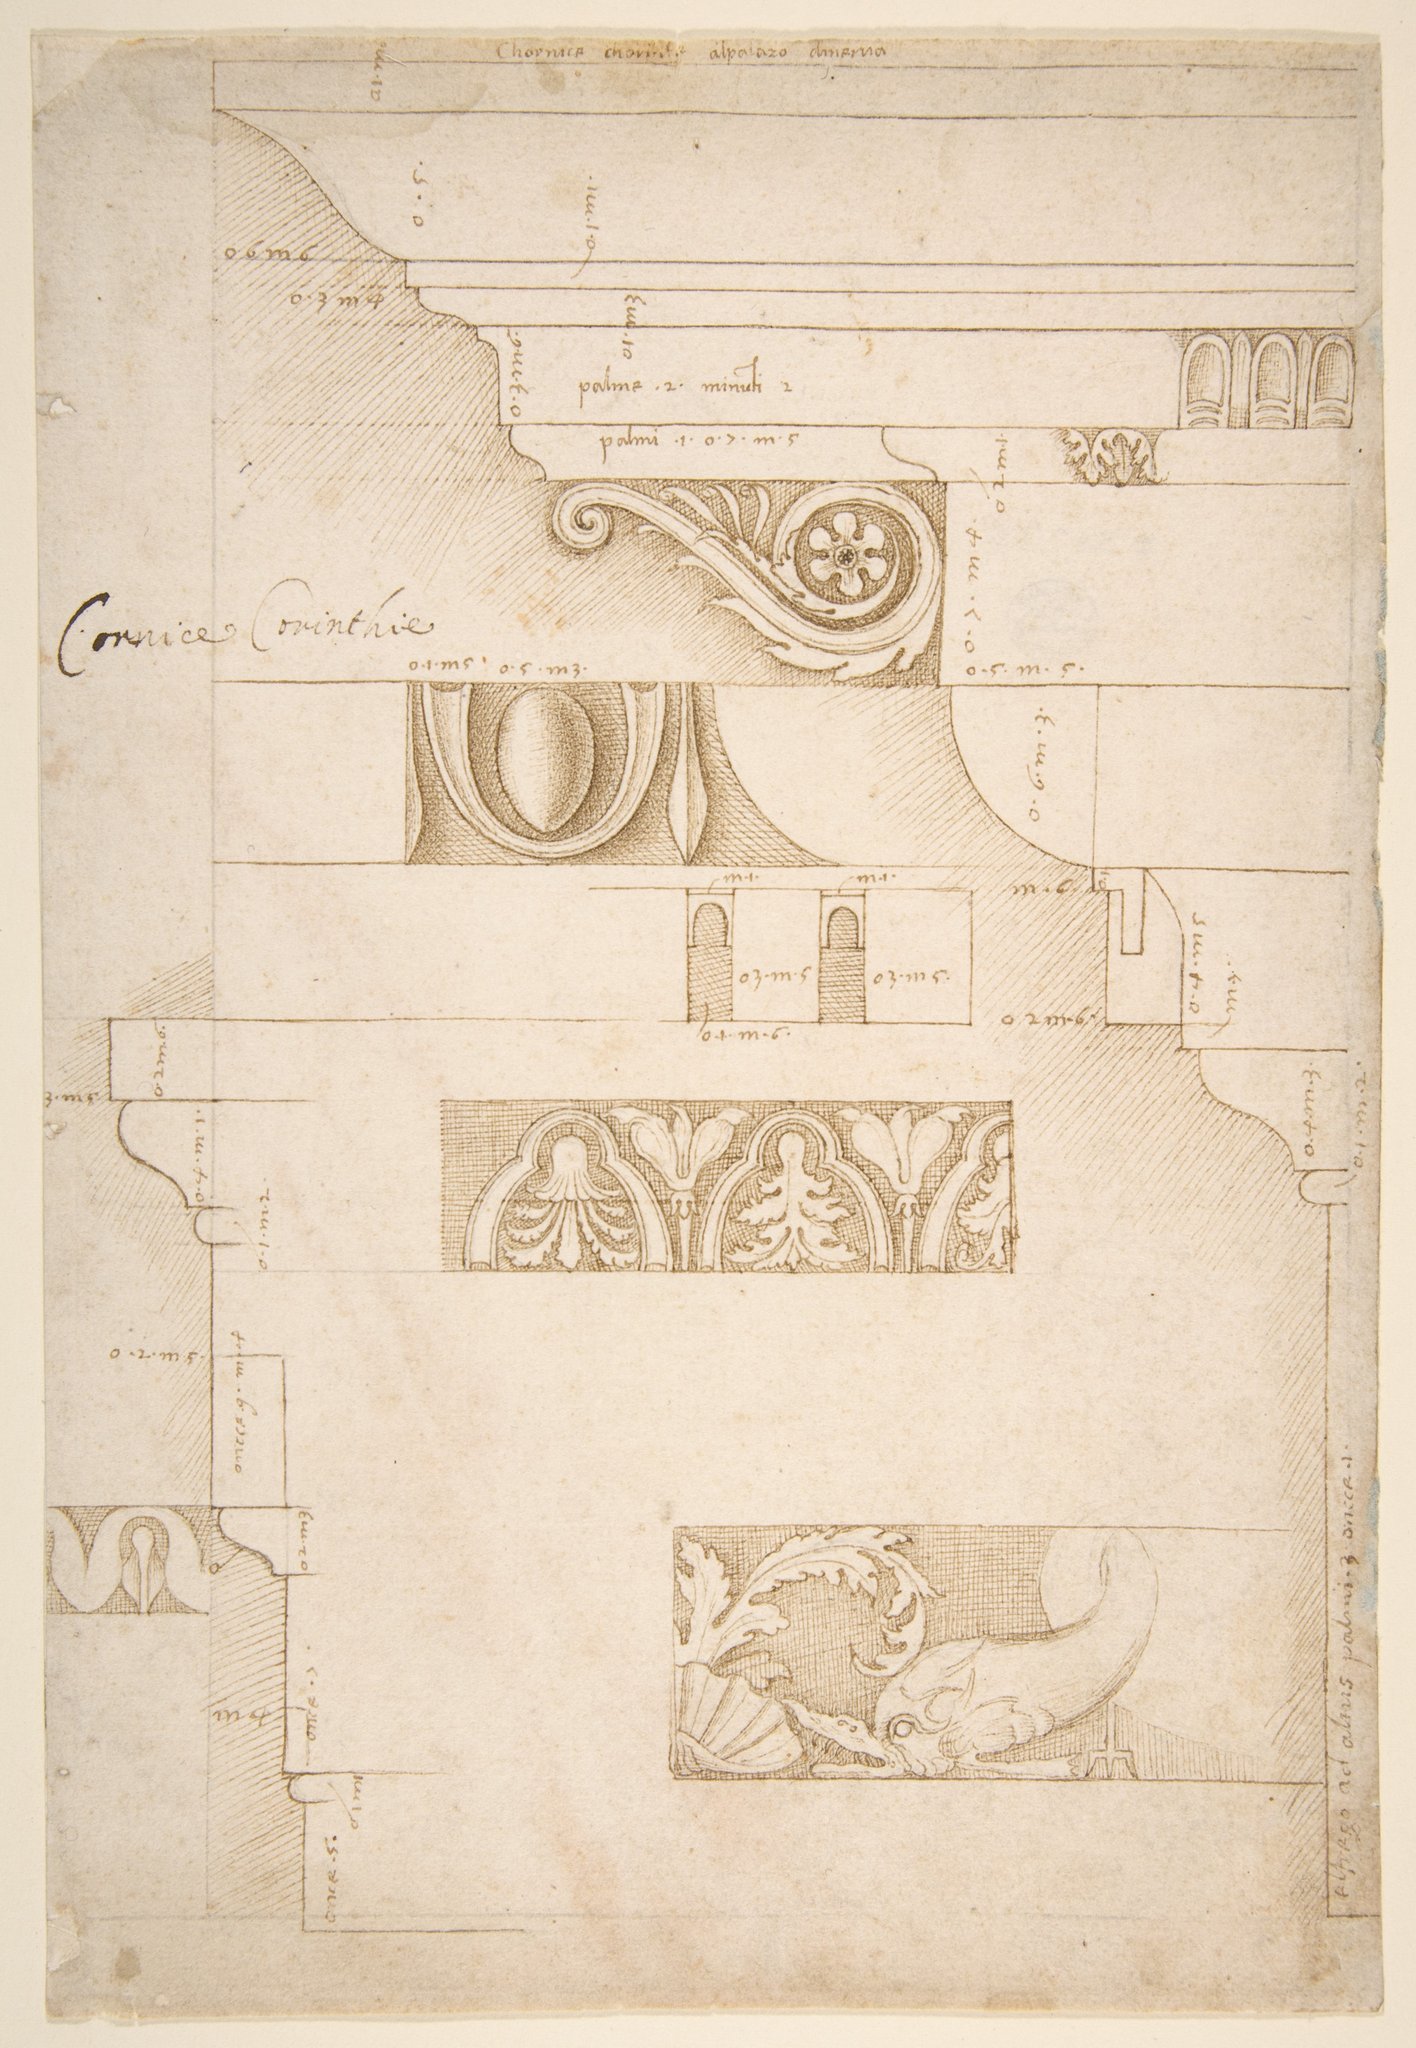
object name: drawing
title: Architectural Study: The Measured Profiles of the Cornice and Entablature of the "Colonnacce" from the Forum Transitorium (the "Palace of Nerva")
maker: sangallo family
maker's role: artist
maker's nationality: italian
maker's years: 1510-1520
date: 1500-1520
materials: ink, drawing material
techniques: pen